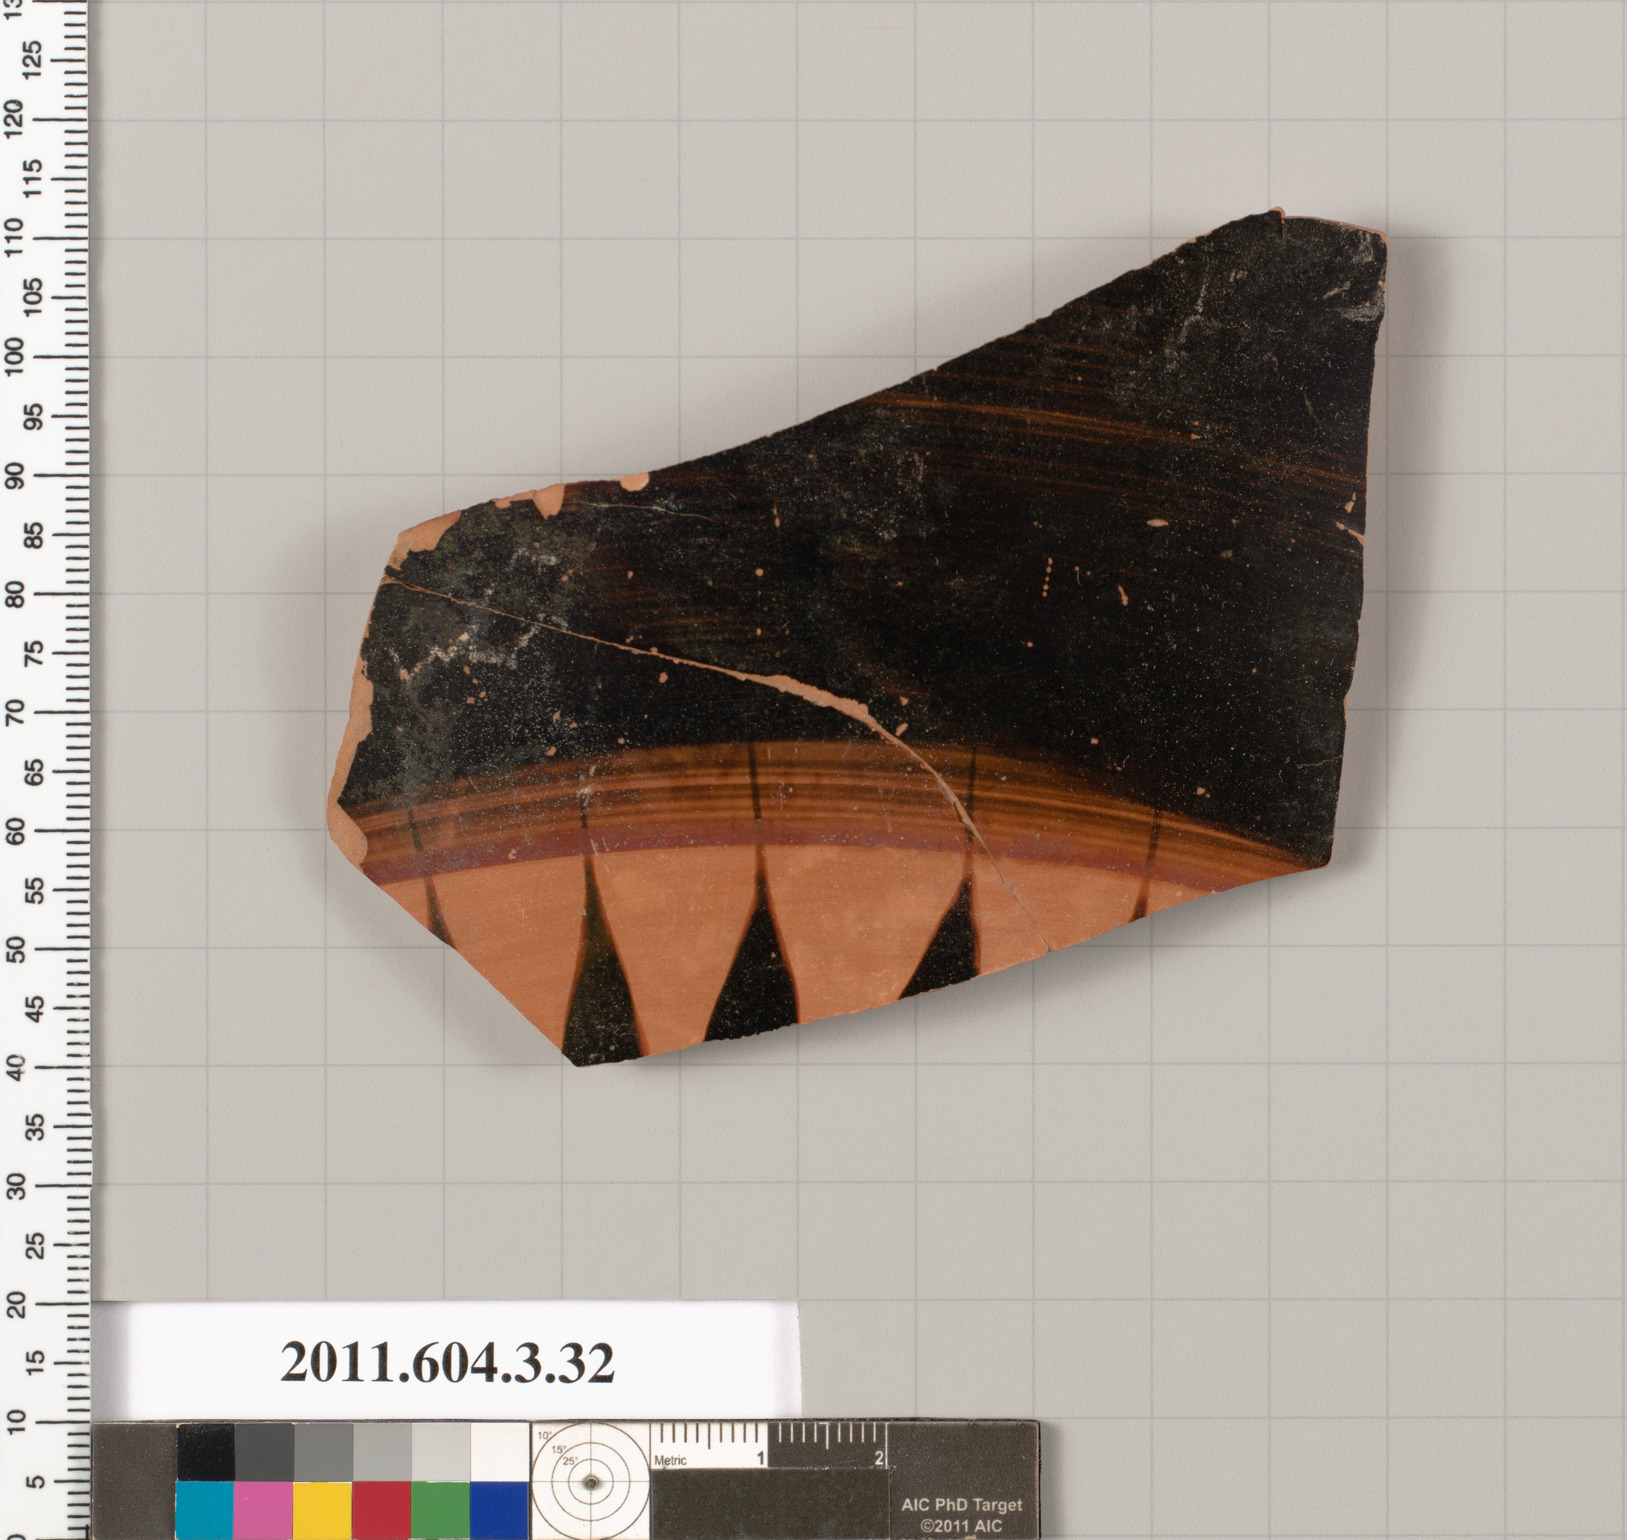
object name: amphora fragment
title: Terracotta fragment of an amphora (jar)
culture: greek, attic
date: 540-500 BCE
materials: terracotta